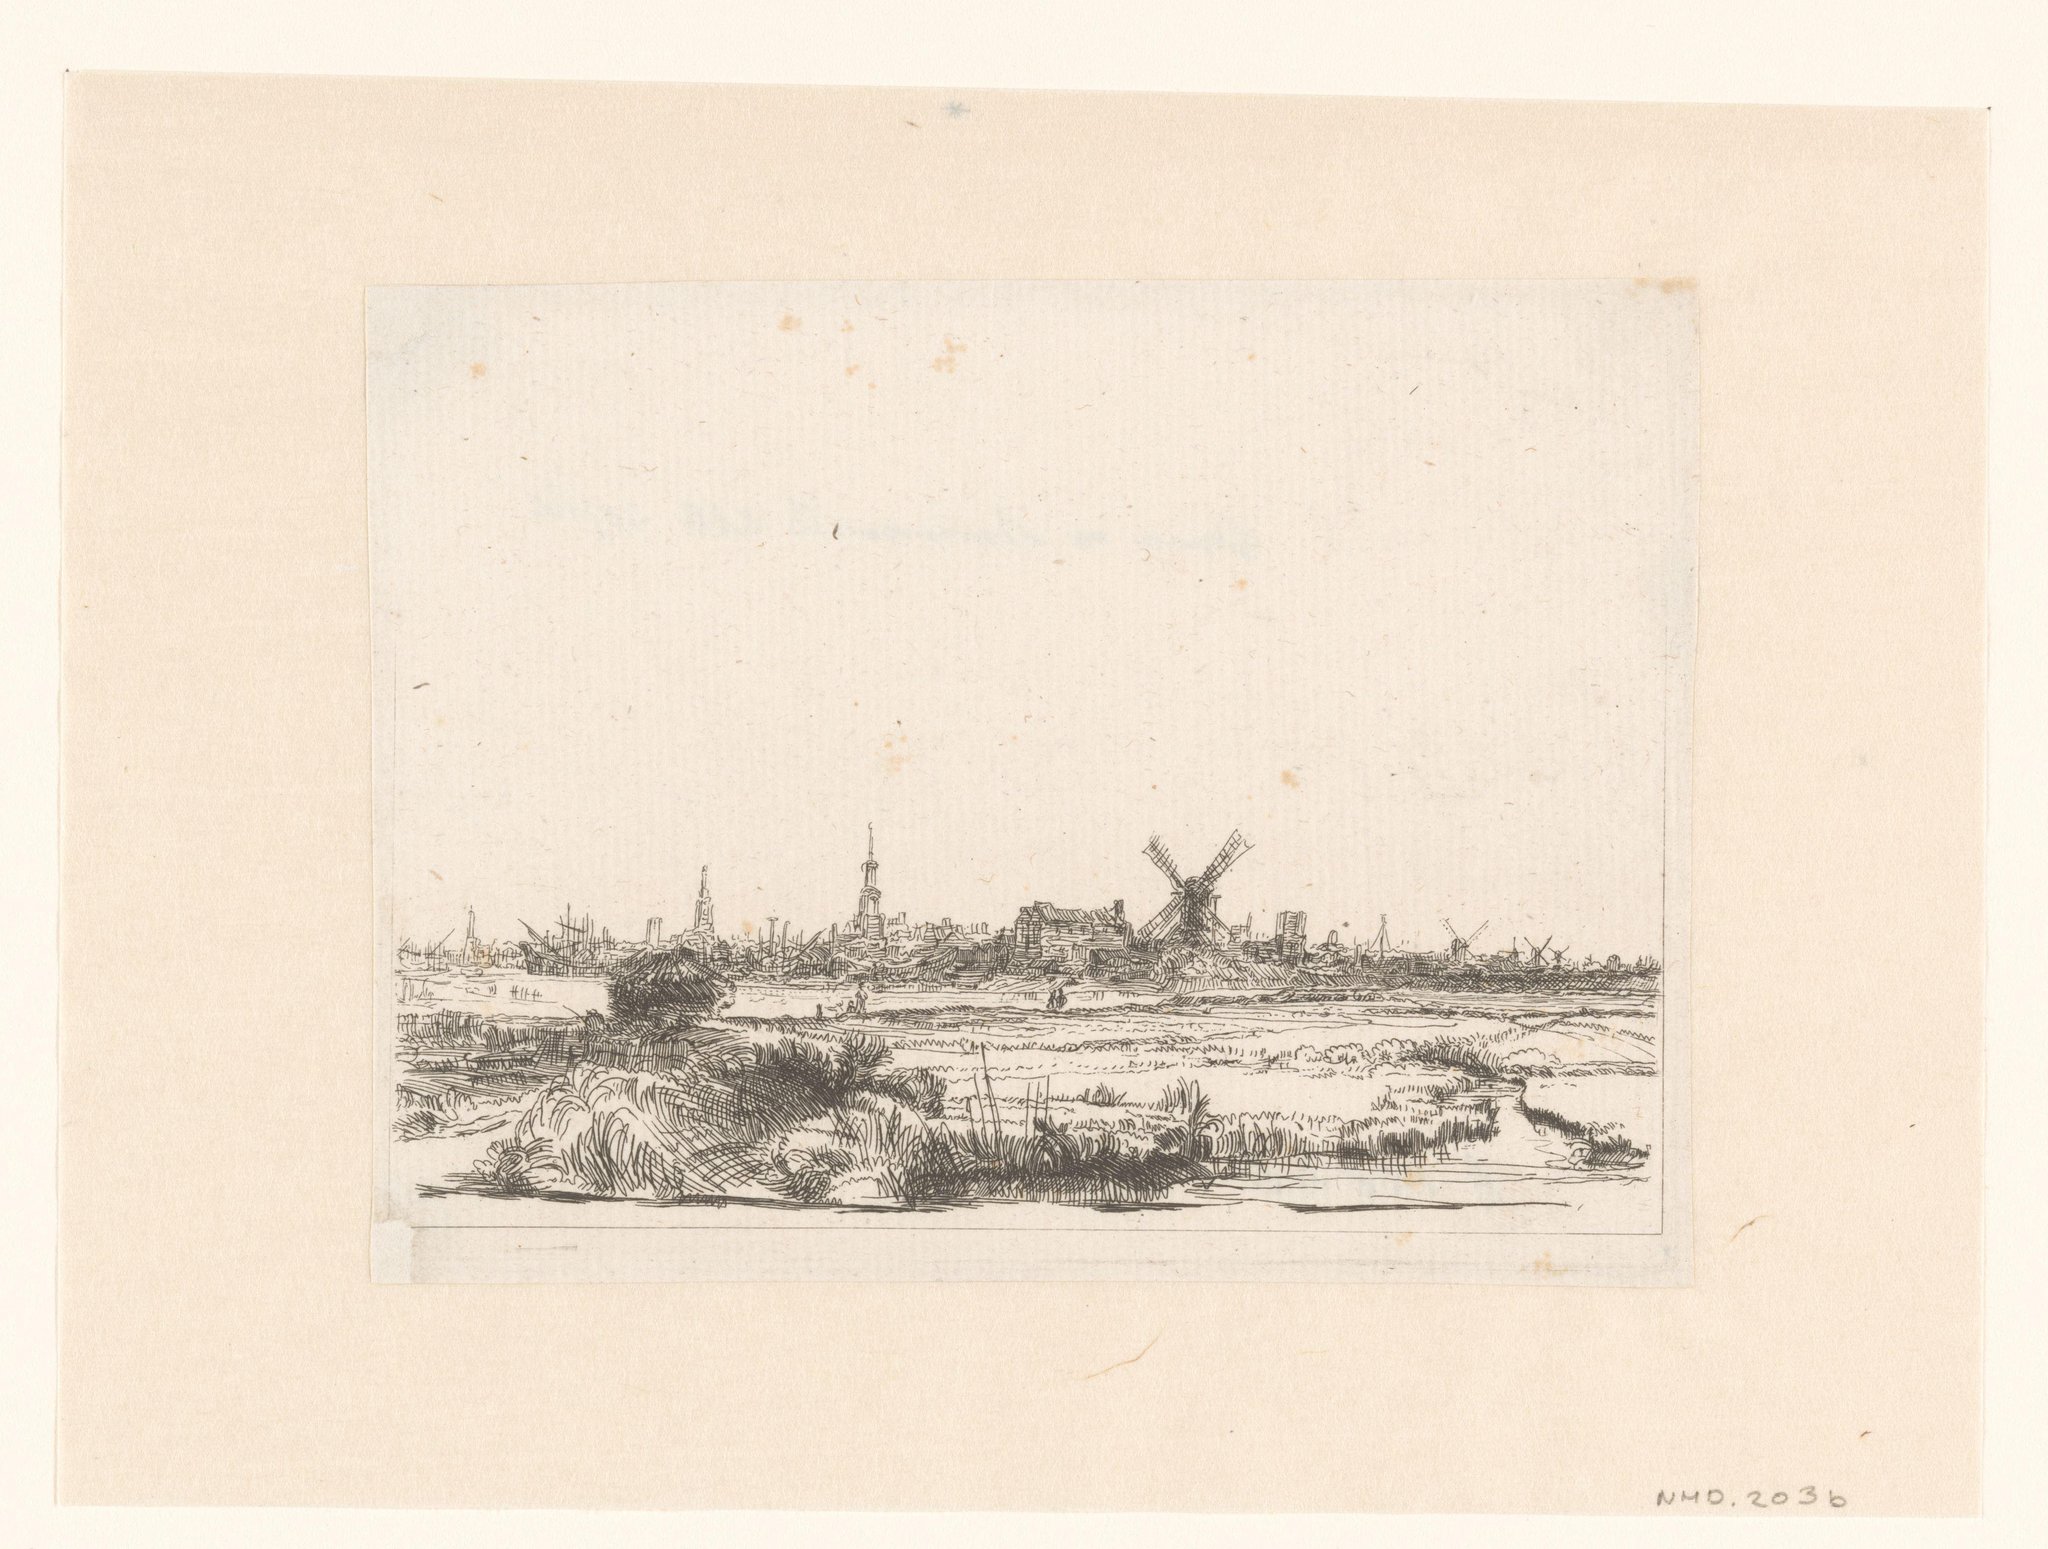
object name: print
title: View of Amsterdam from the Kadijk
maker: william young ottley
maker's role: print maker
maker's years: 1771-1836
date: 1828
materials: paper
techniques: etching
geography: london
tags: amsterdam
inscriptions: collector's mark: Lugt 2228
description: Prent voor het eerst gebruikt in: Ottley, William Young. A collection of thirty-nine facsimiles, rare etchings, by celebrated painters of the Italian, Dutch and Flemish schools. Londen: s.n., 1828.